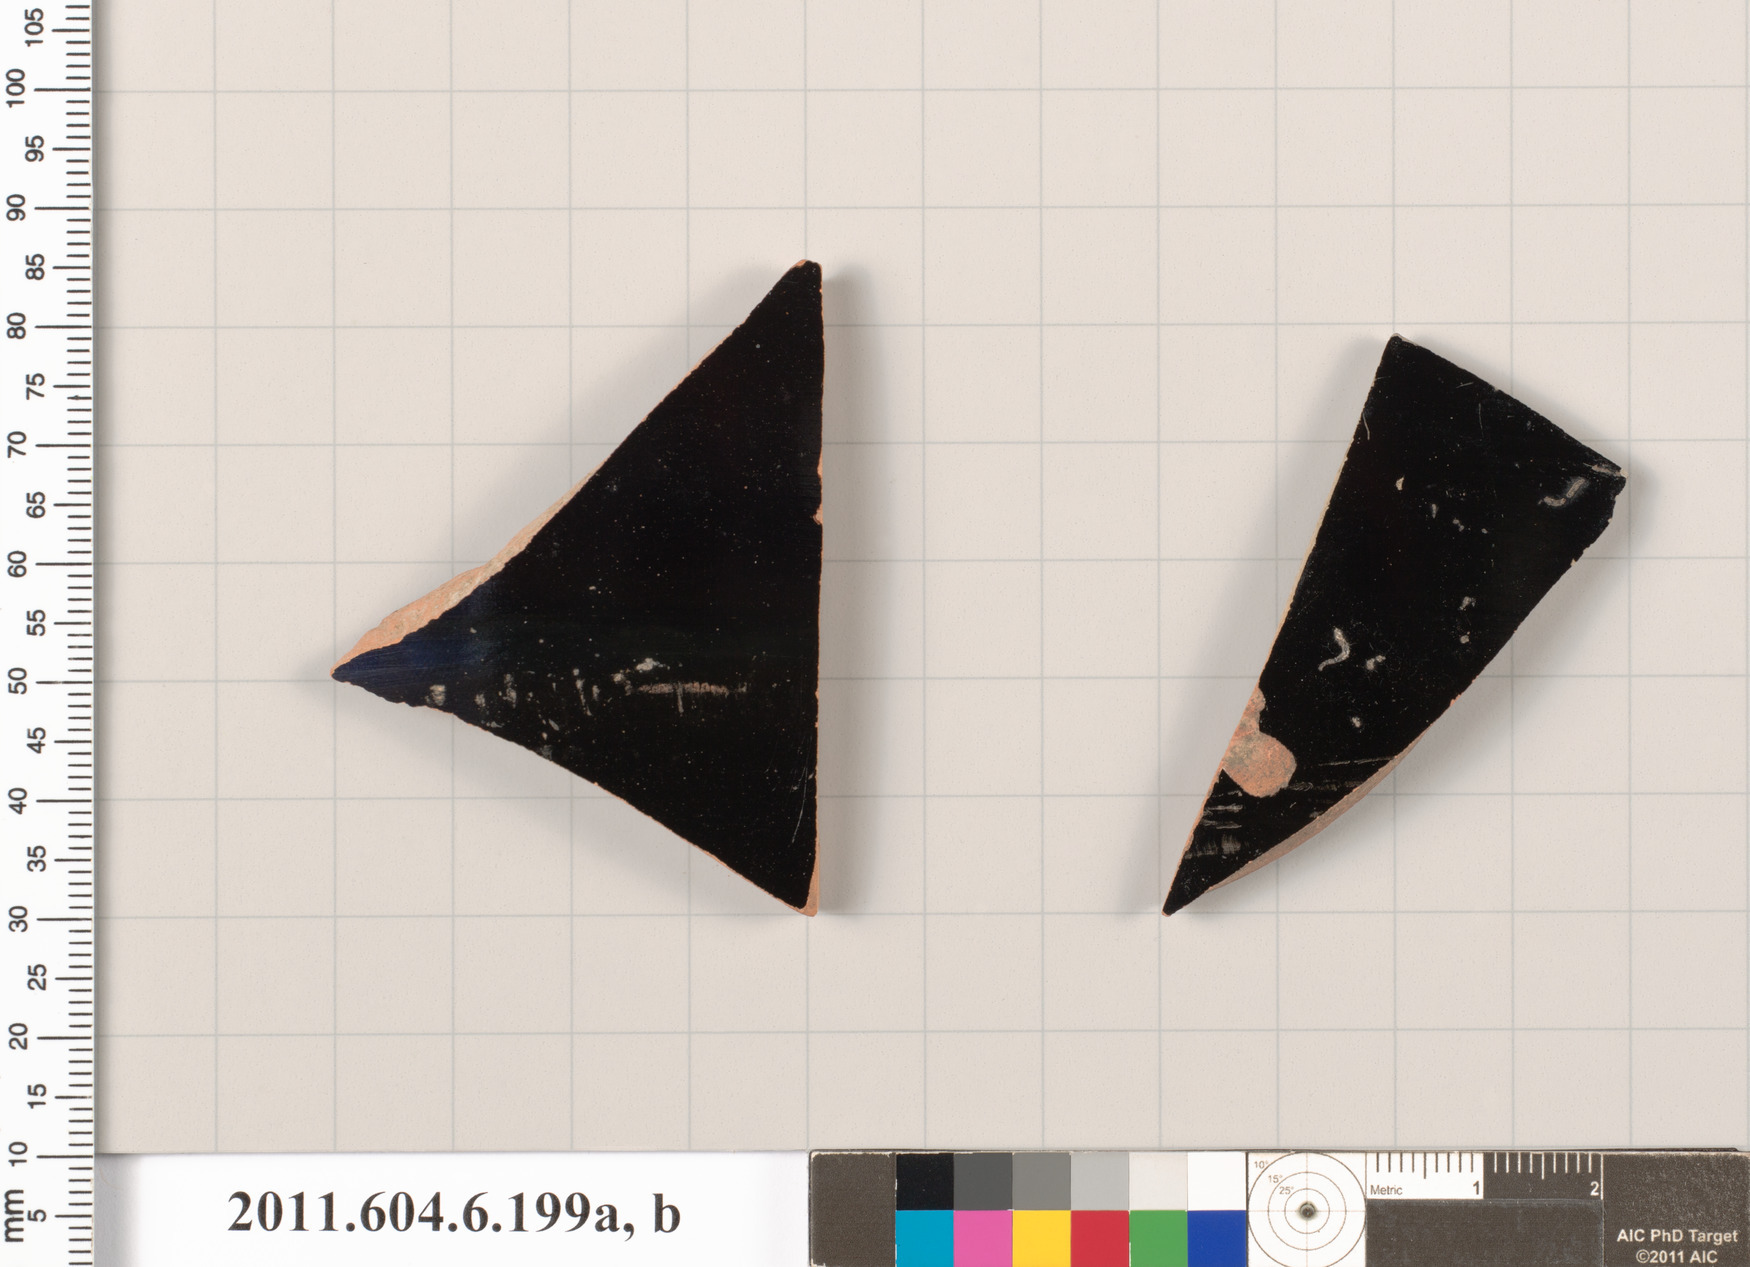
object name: skyphos fragment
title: Terracotta fragments of skyphoi (deep drinking cups)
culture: greek, attic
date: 500-401 BCE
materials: terracotta